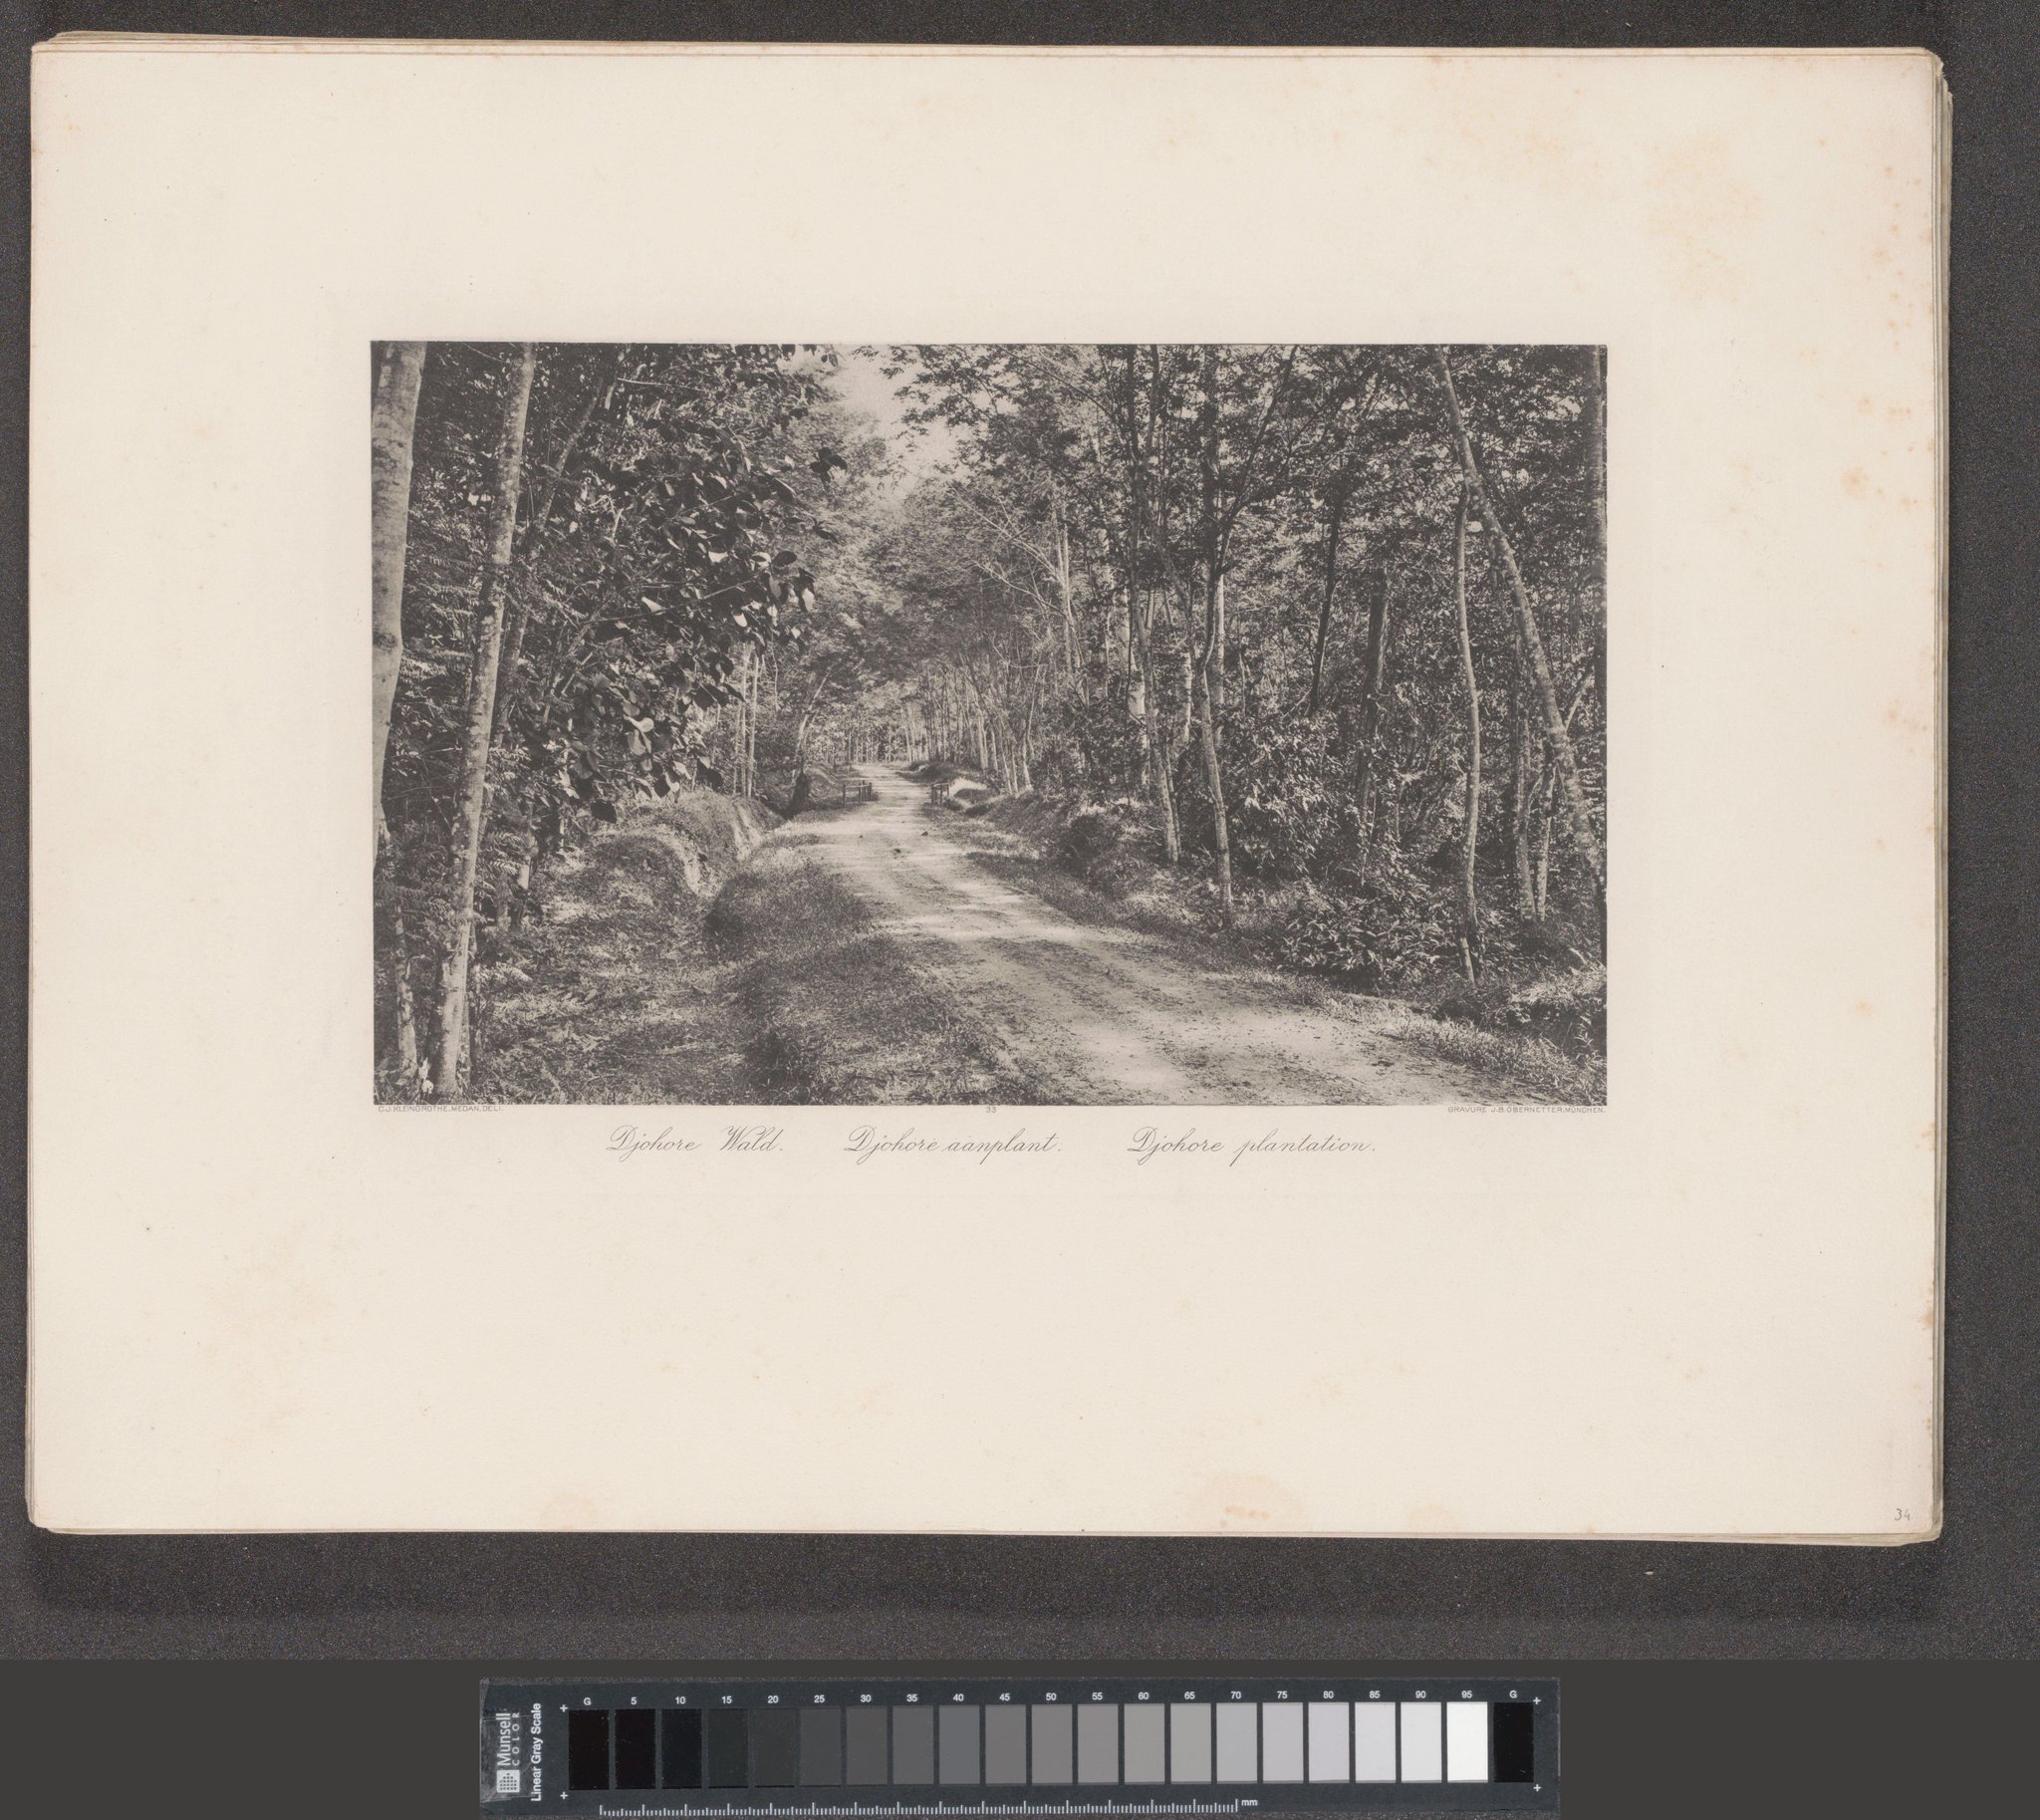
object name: photomechanical print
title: Djohore aanplant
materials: paper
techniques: photoaquatint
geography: sumatra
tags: plantation, road, path, sumatra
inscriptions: number: ‘33’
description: Onderdeel van Album met heliogravures van Sumatra's oostkust.